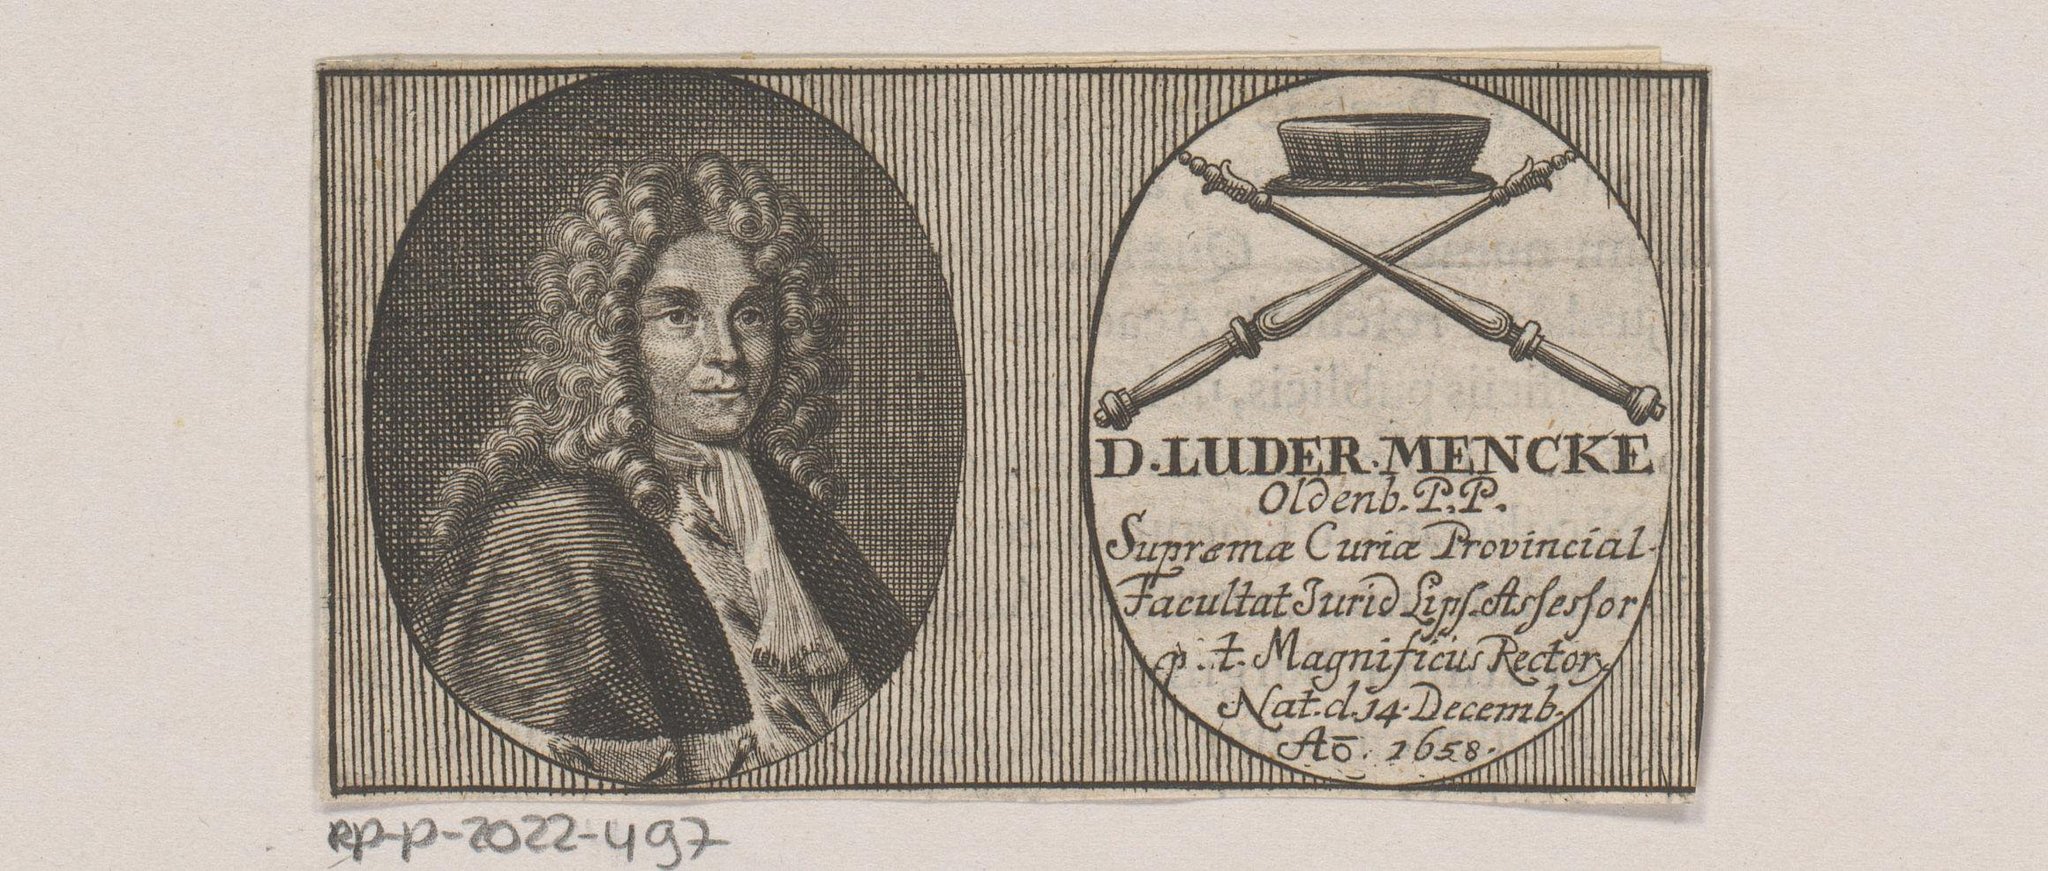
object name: print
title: Portret van Lüder Mencke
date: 1709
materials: paper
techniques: engraving, letterpress printing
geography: leipzig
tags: historical persons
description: Prent uit: Ittig, Thomas. Historiae ecclesiasticae primi a christo nato seculi selecta capita. Leipzig: Johannes Grossius en Jo. Frider Braun, 1709.